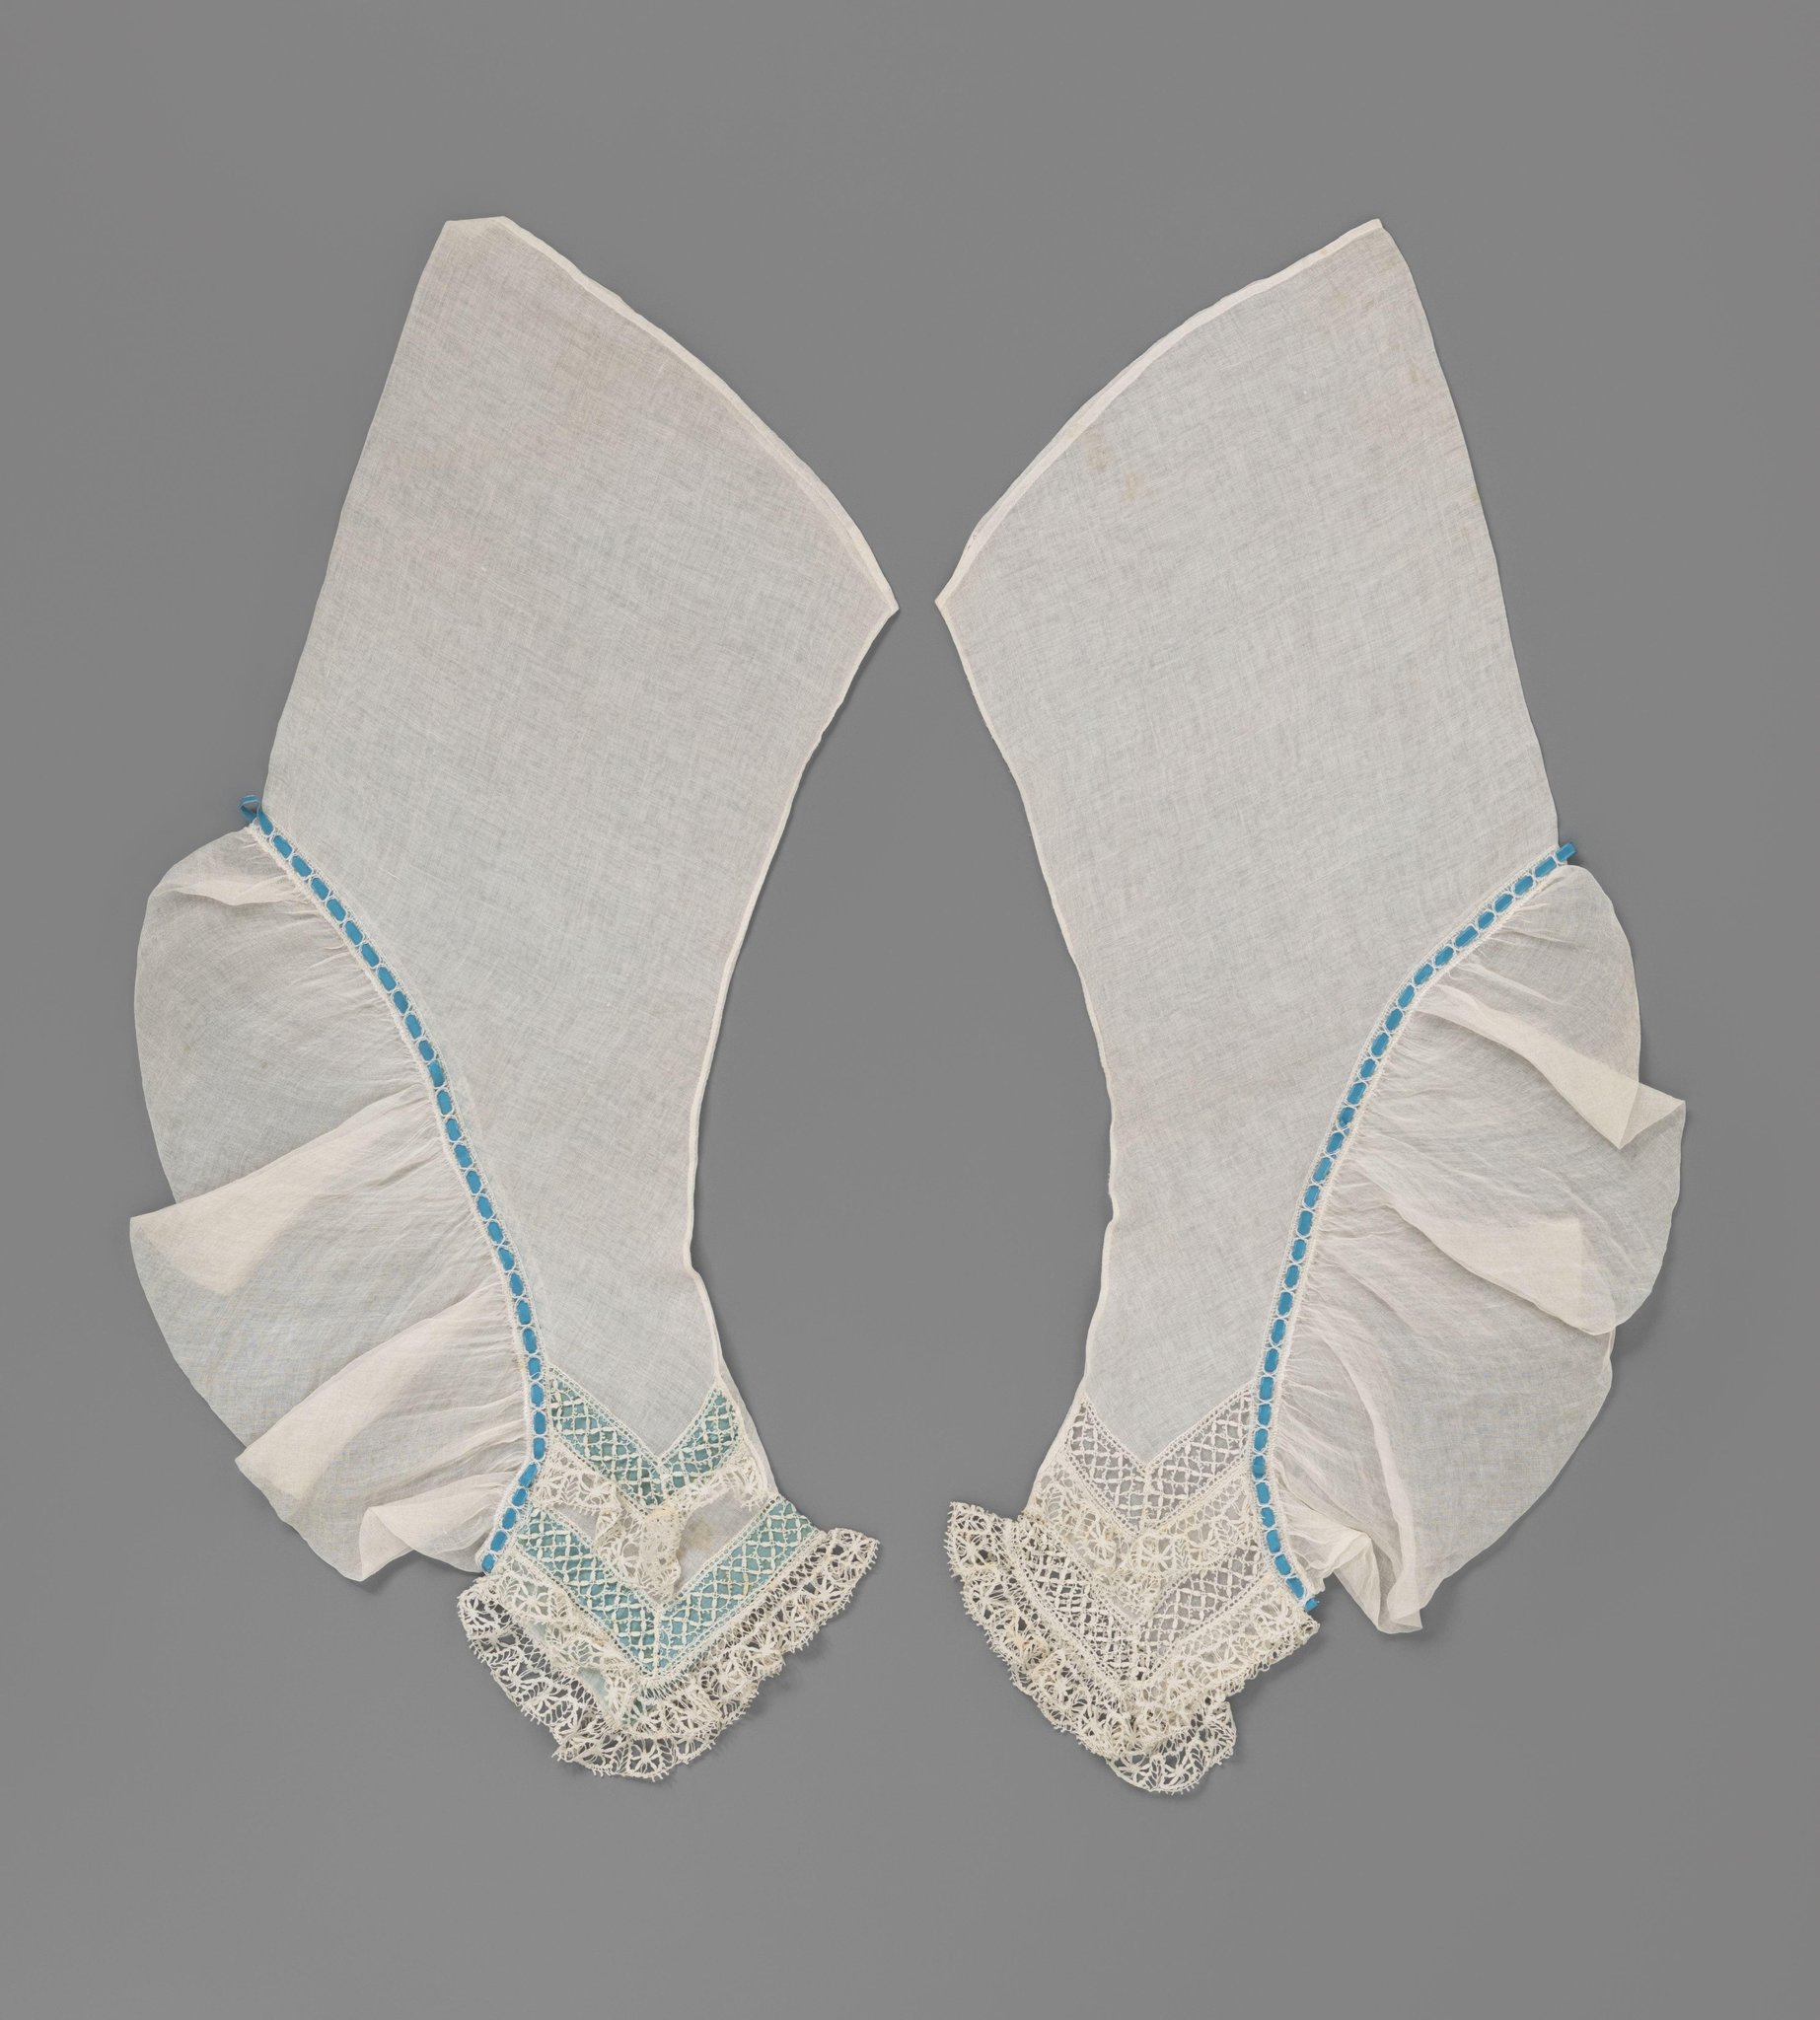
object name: undersleeve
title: Ondermouw van batist met doorgeregen blauw satijnen lint en kanten manchet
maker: Anonymous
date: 1850-1900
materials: textile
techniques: lace, cockled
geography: western europe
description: Ondermouw van katoenbatist met een aangerimpelde strook die loopt van de elleboog tot aan de pols. Tussen de mouw en deze strook een rand kant, waar een blauw satijnen lint doorheen is geweven. Manchet met twee entre-deux’ van kloskant op een blauw fond. Daartussen een rand aangerimpelde kloskant. Aan de manchet eveneens een aangerimpelde strook kloskant.